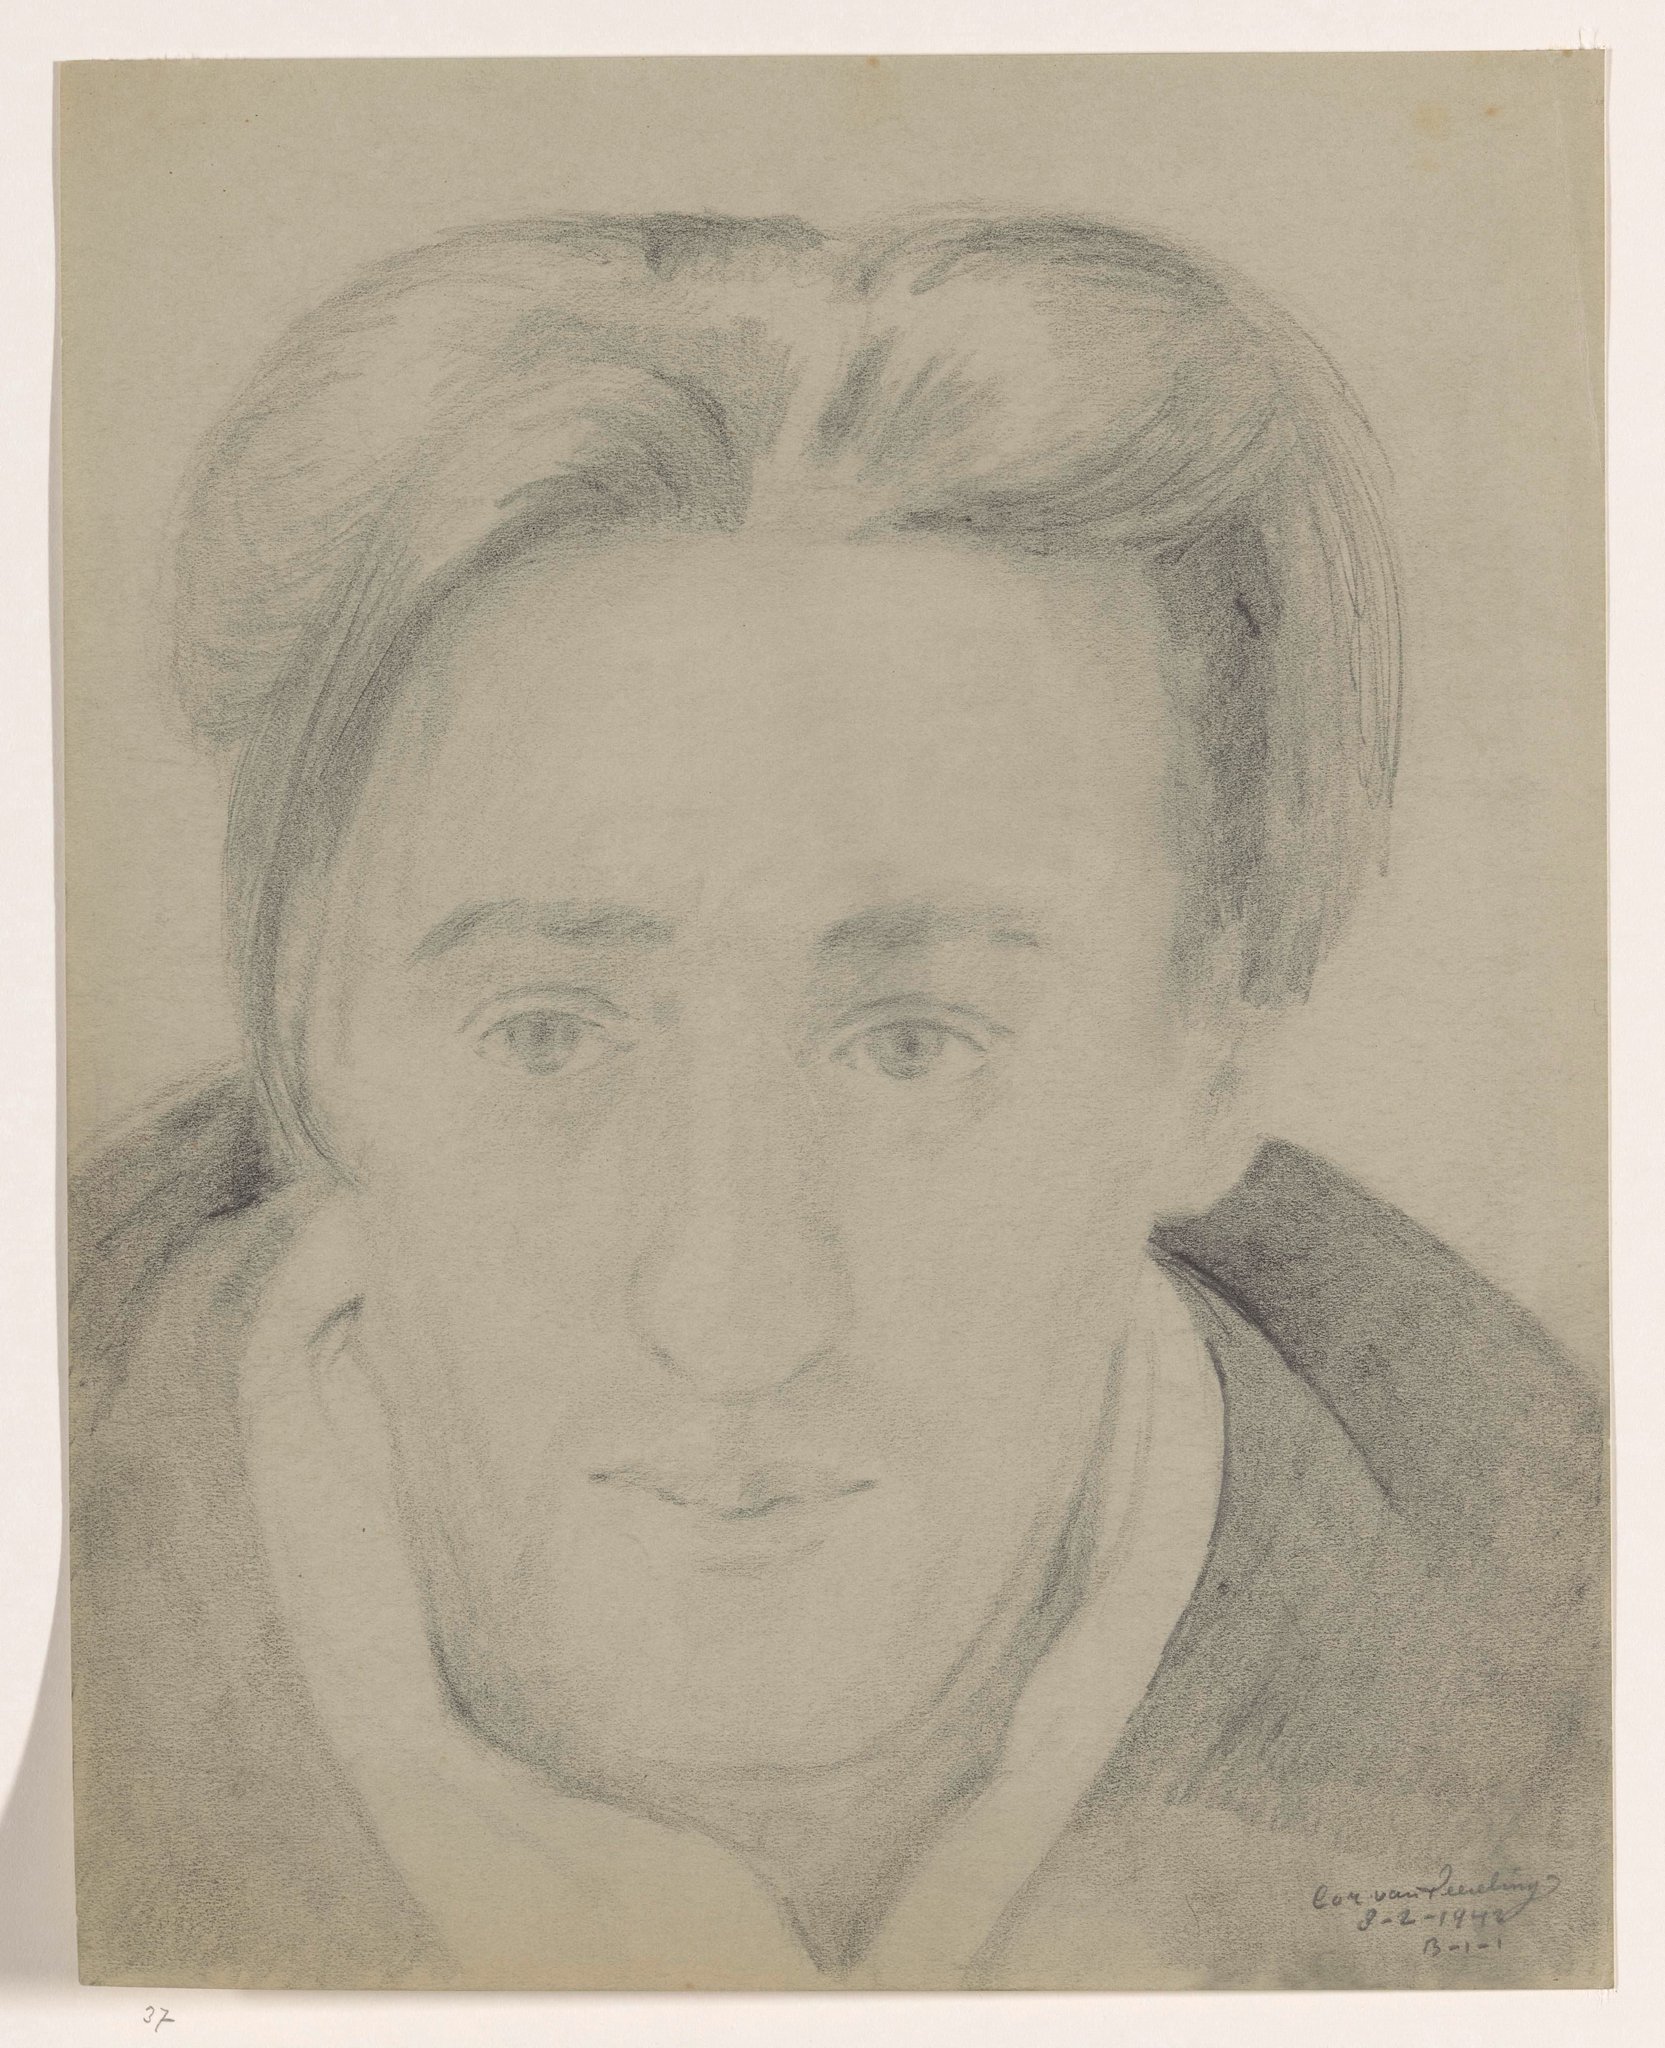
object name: drawing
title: Zelfportretten van Cor van Teeseling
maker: cor van teeseling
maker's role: draughtsman, sculptor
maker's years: 1915-1942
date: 1942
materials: paper, pencil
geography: weteringschans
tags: amsterdam, draughtsman, sculptor, cor van teeseling, historical persons, prisoner in cell or locked place, portrait, self-portrait of draughtsman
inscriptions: inscription: ‘Hauptzollamt Wien’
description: Zelfportret van Cor van Teeseling: B-1-1, 8 februari. Getekend zelfportret van Cor van Teeseling en face.